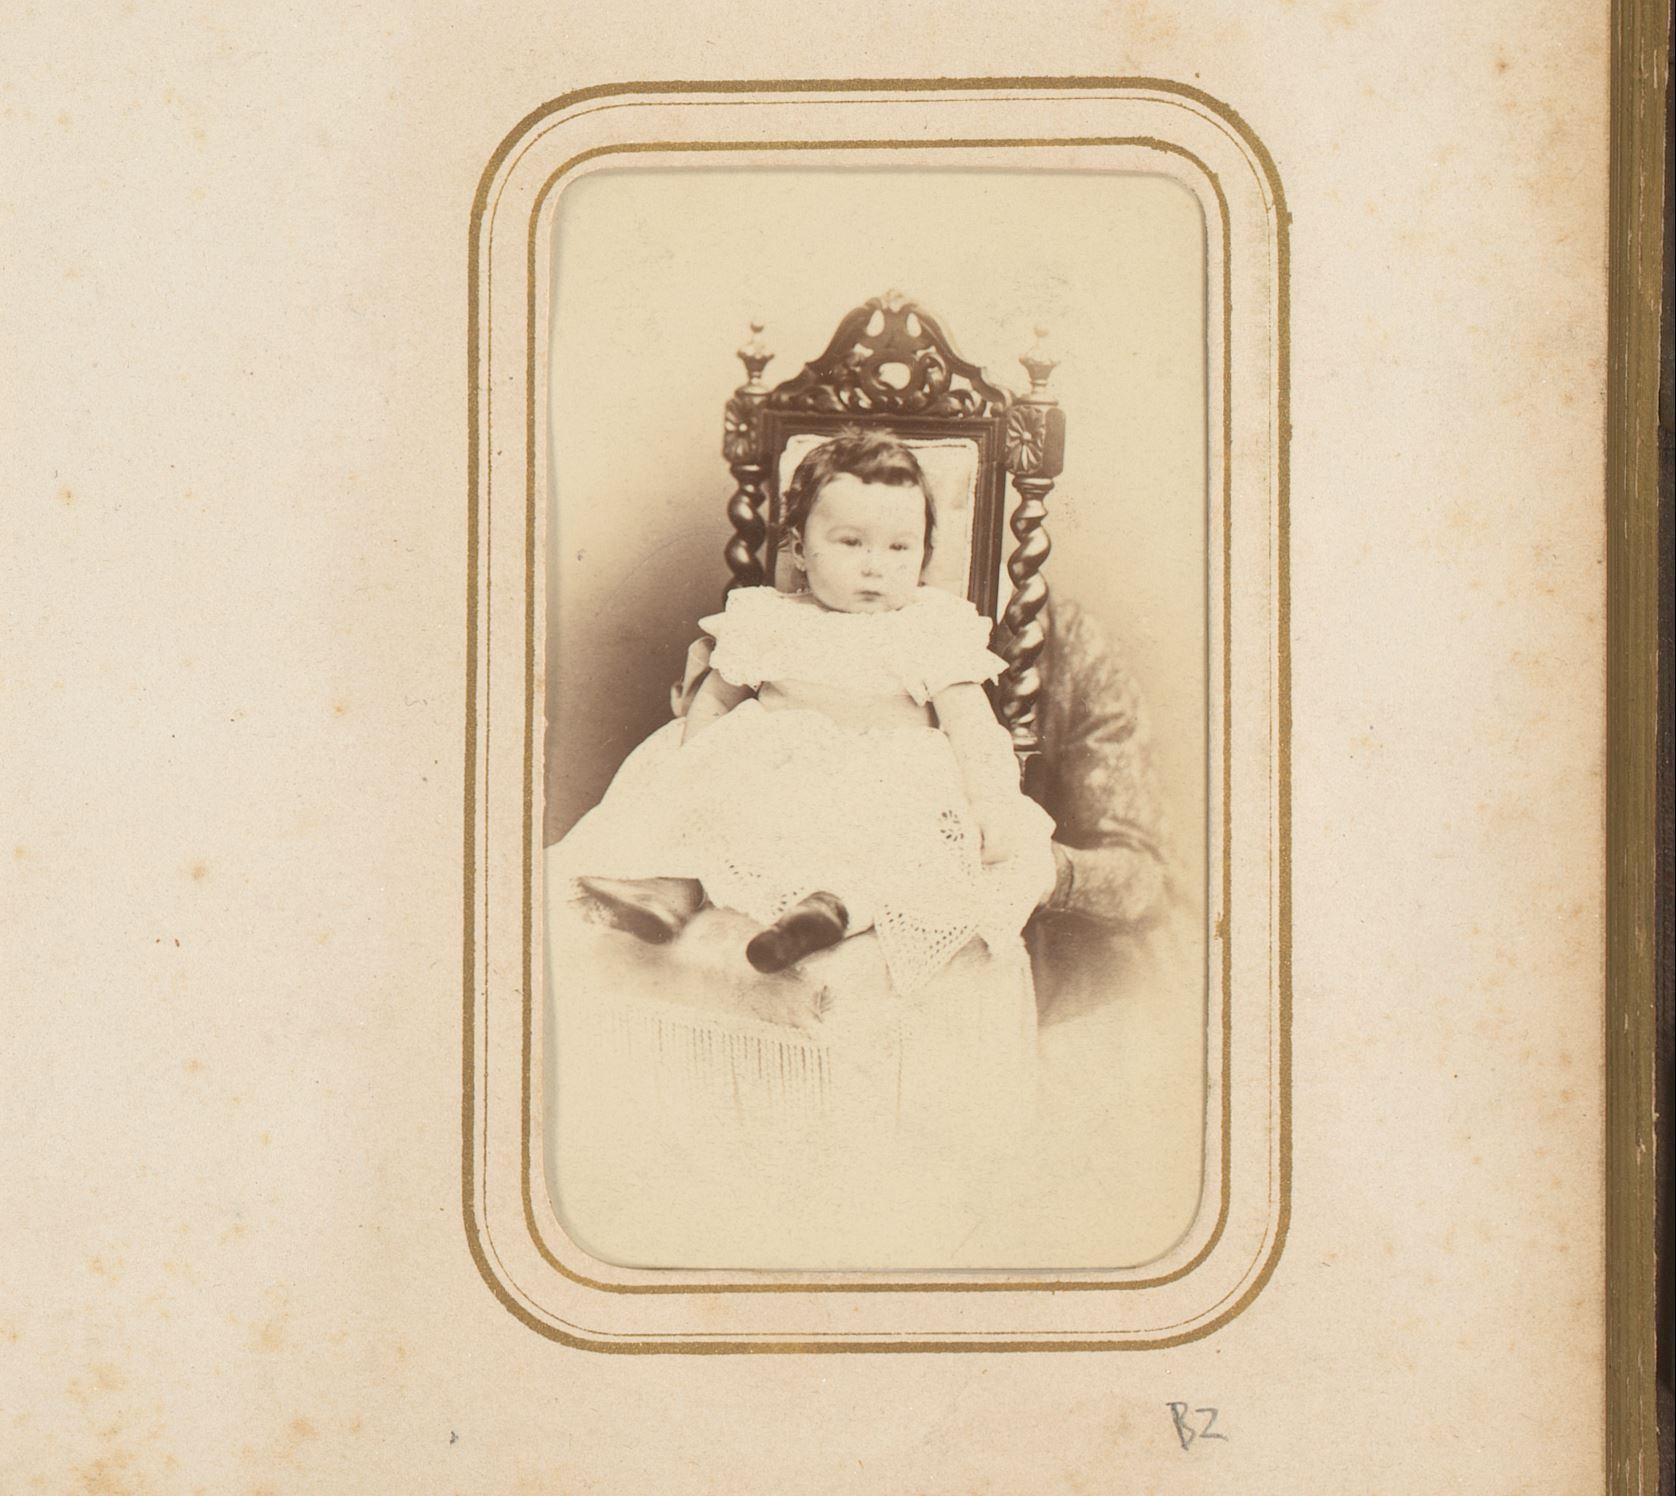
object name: photograph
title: Portret van een baby, aangeduid als Louise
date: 1865-1900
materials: cardboard, photographic support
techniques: albumen print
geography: netherlands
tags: infant, baby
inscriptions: annotation: ‘4 ocotober/ Louise 10 mois’, inscription: ‘Photogr. Atelier/ Wegner & Mottu/ Kalverstraat/ over den Heyligenweg D26/ Amsterdam/ Leydsche Straatweg/ Buiten Cathrynen/ Utrecht’